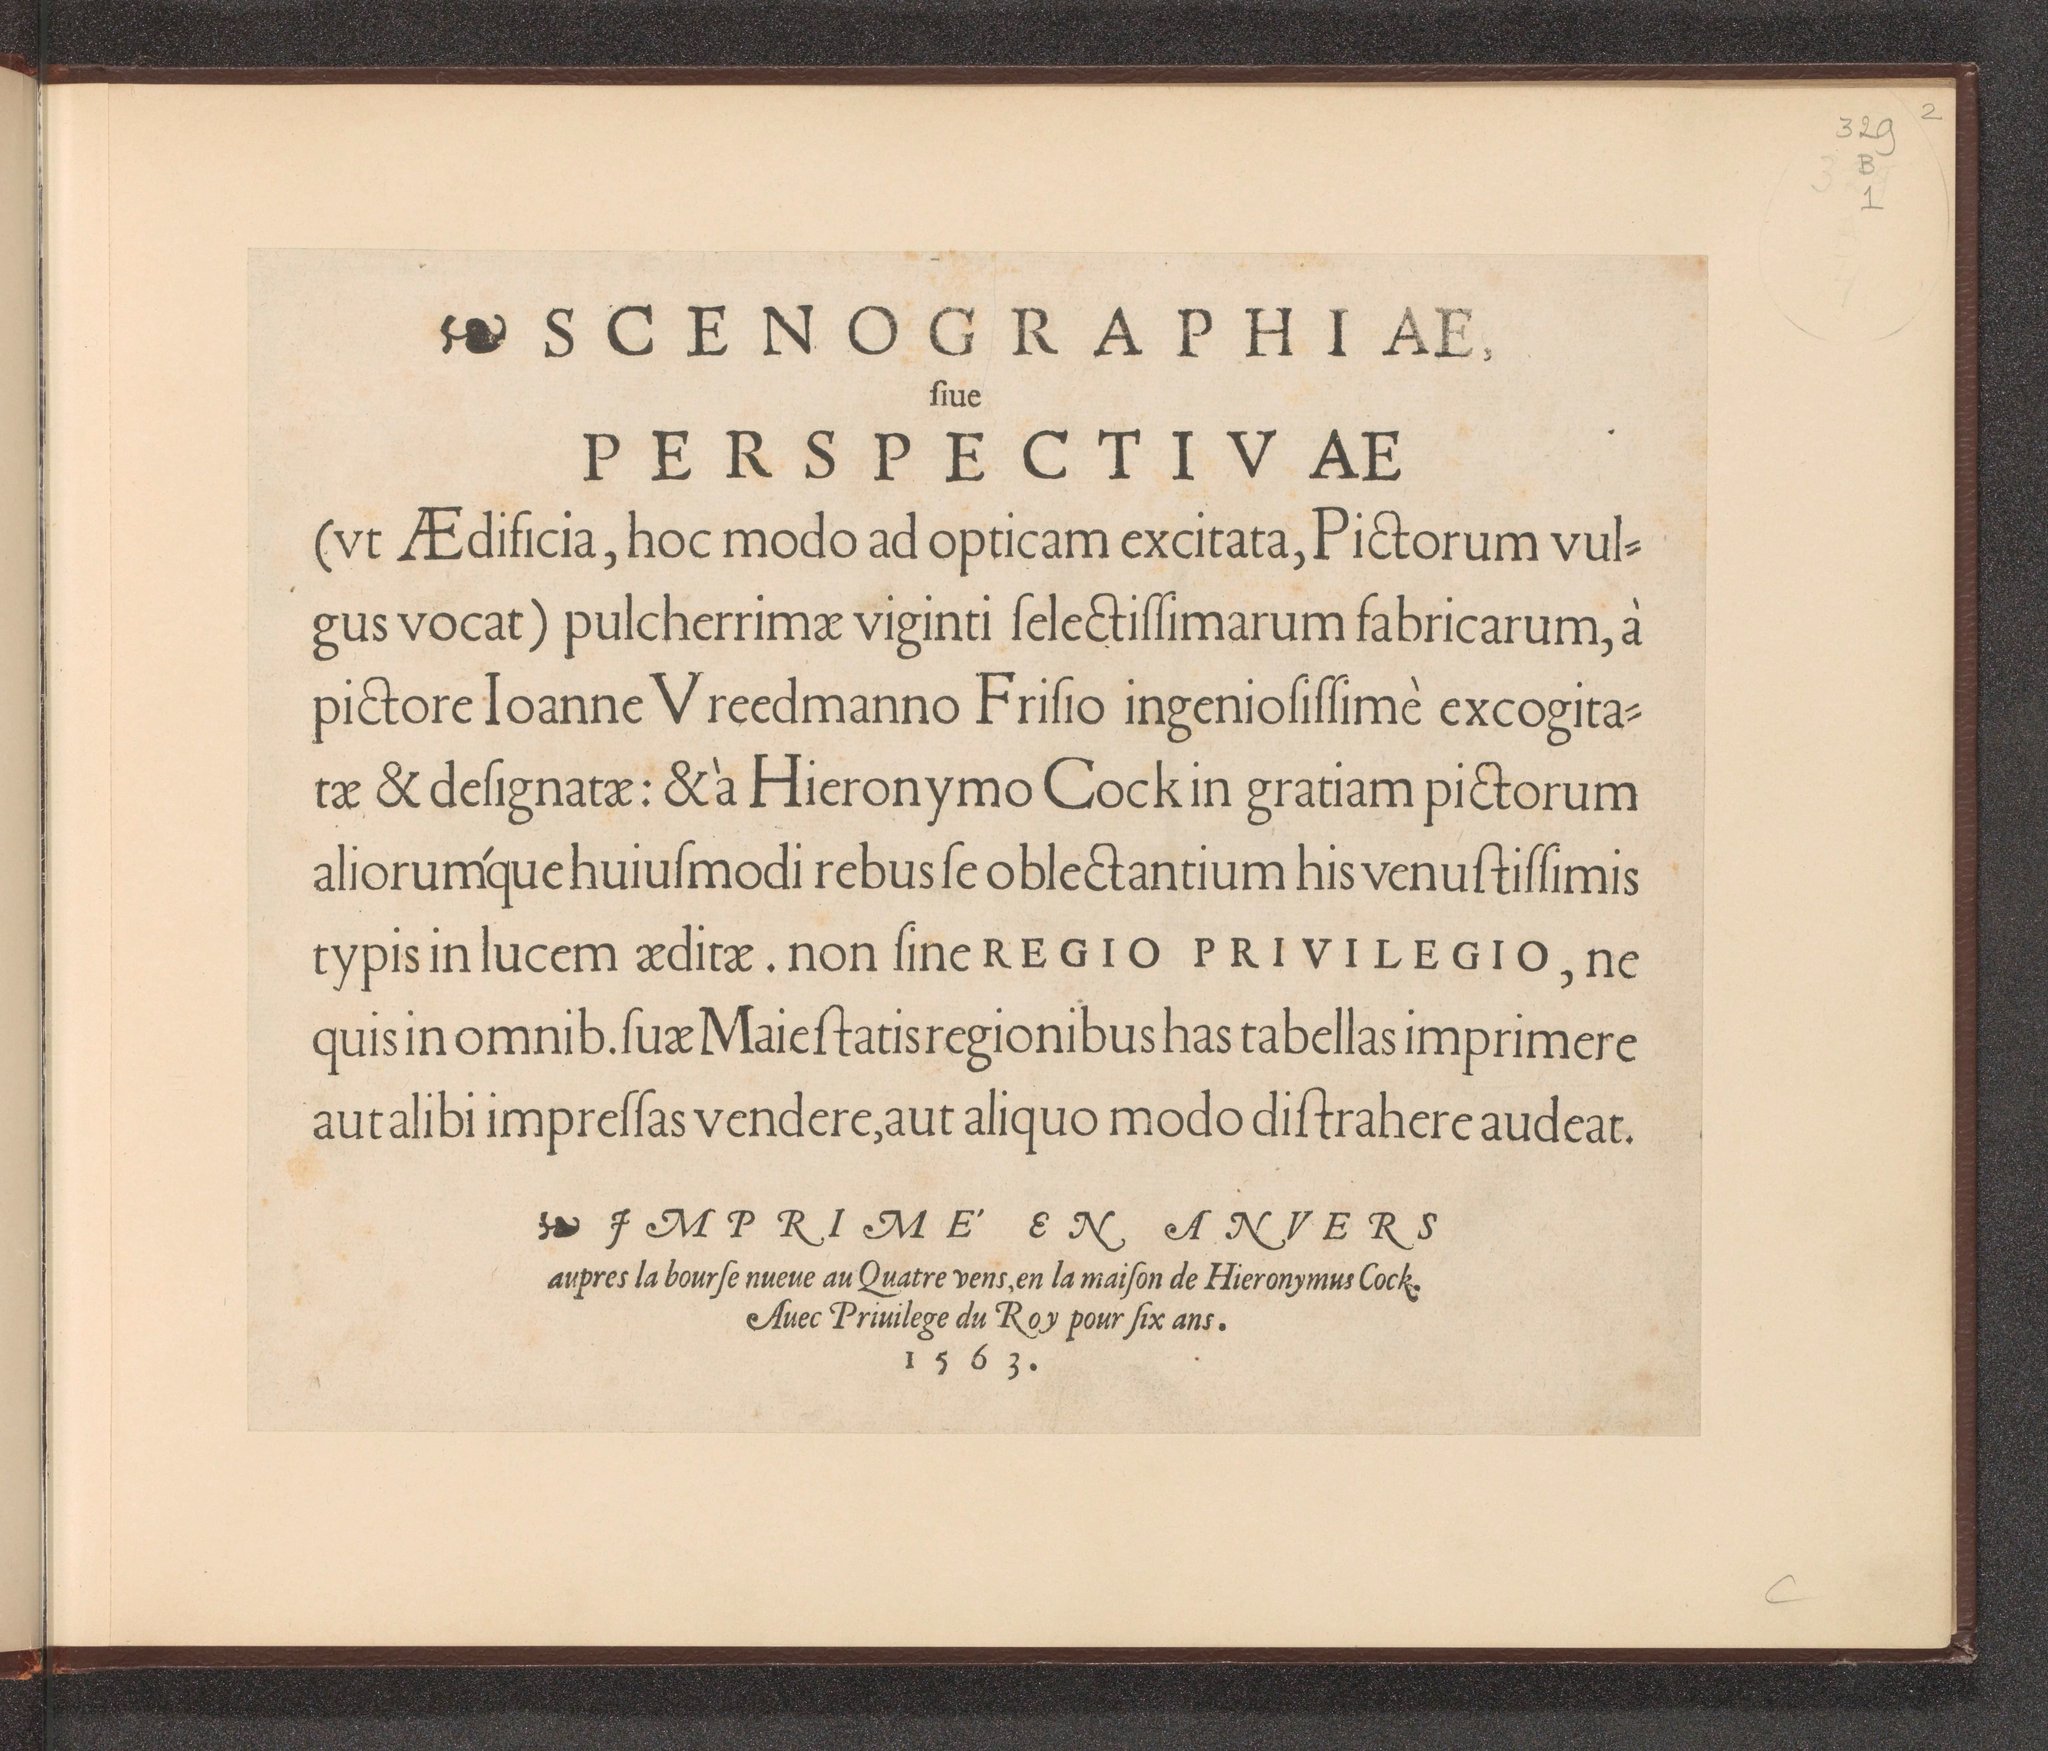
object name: titelblad, titelpagina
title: Titelpagina voor: Scenographiae, sive Perspectivae, 1563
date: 1563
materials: paper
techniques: letterpress printing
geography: antwerp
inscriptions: date